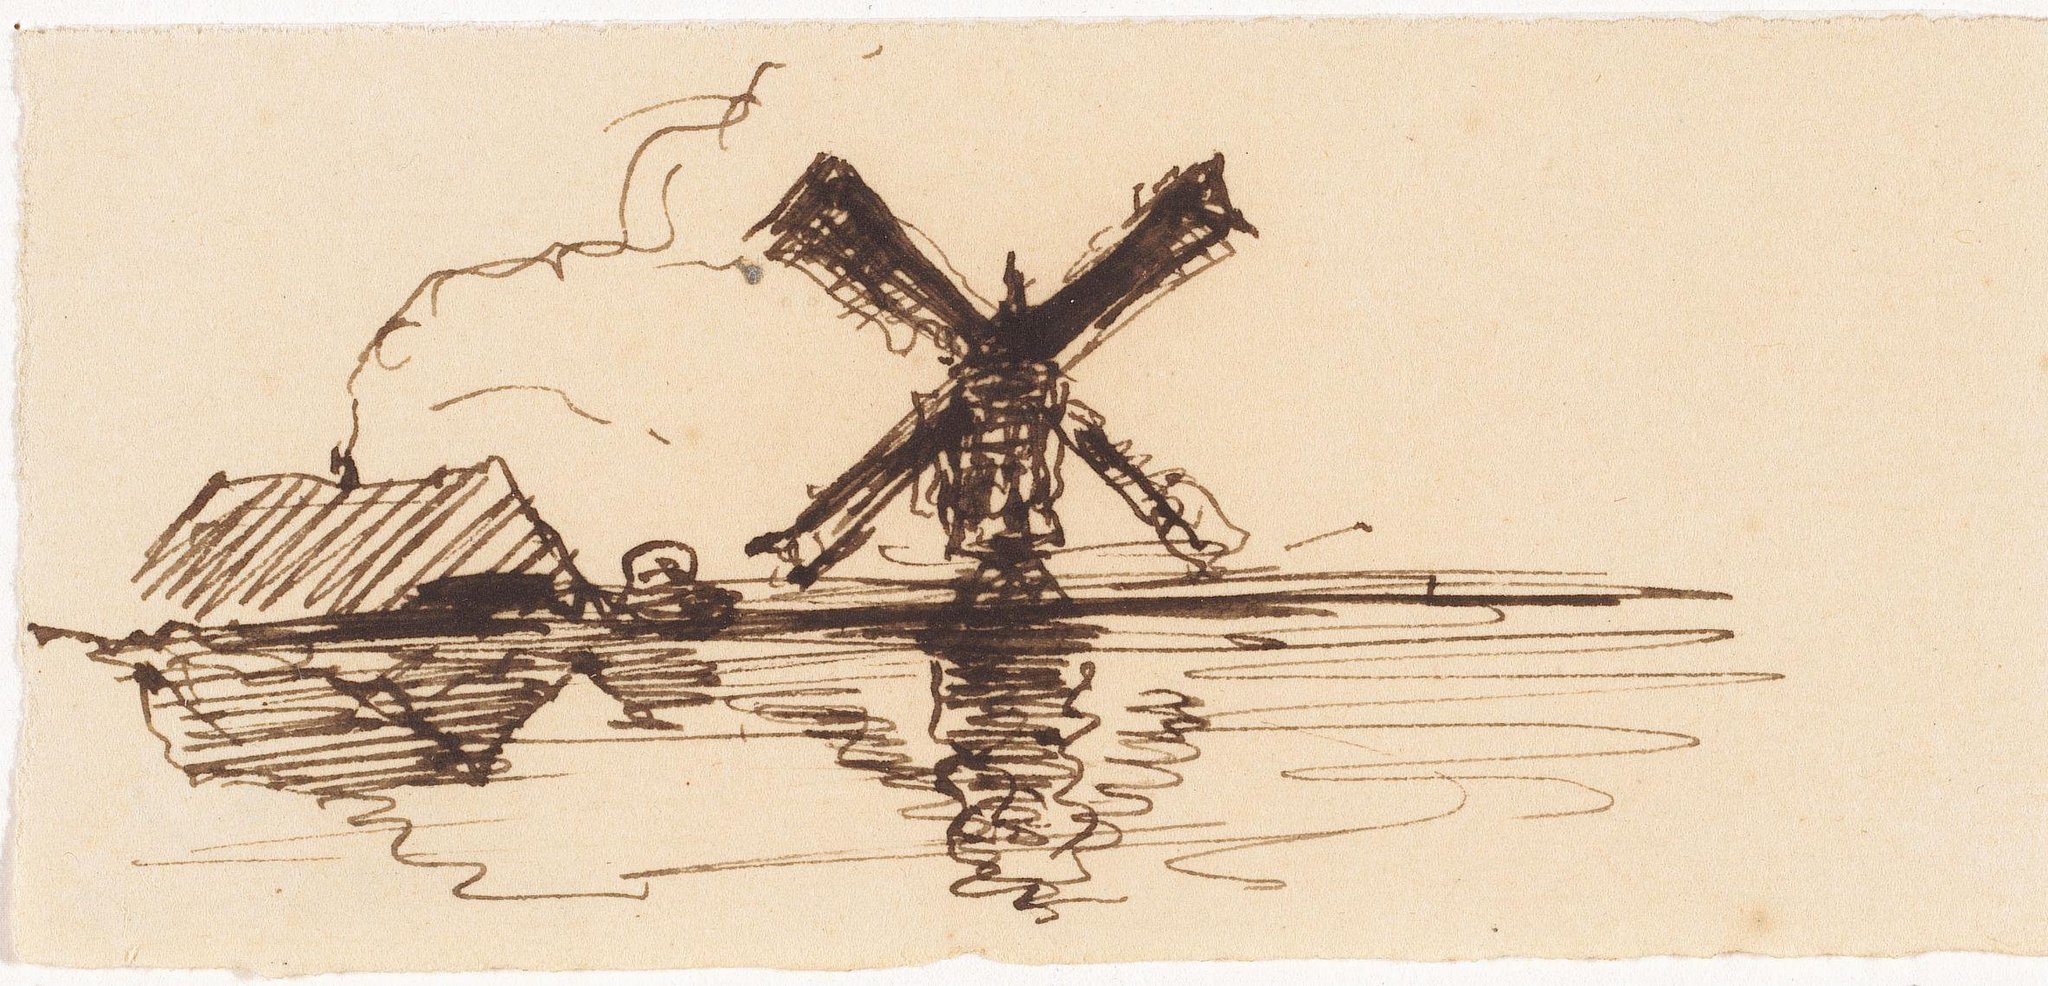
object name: drawing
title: Rivierlandschap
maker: johannes tavenraat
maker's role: draughtsman, painter, print maker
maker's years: 1809-1881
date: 1840-1880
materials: ink, paper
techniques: pen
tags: windmill in landscape, river (+ landscape with figures, staffage)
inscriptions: collector's mark: Lugt 2228